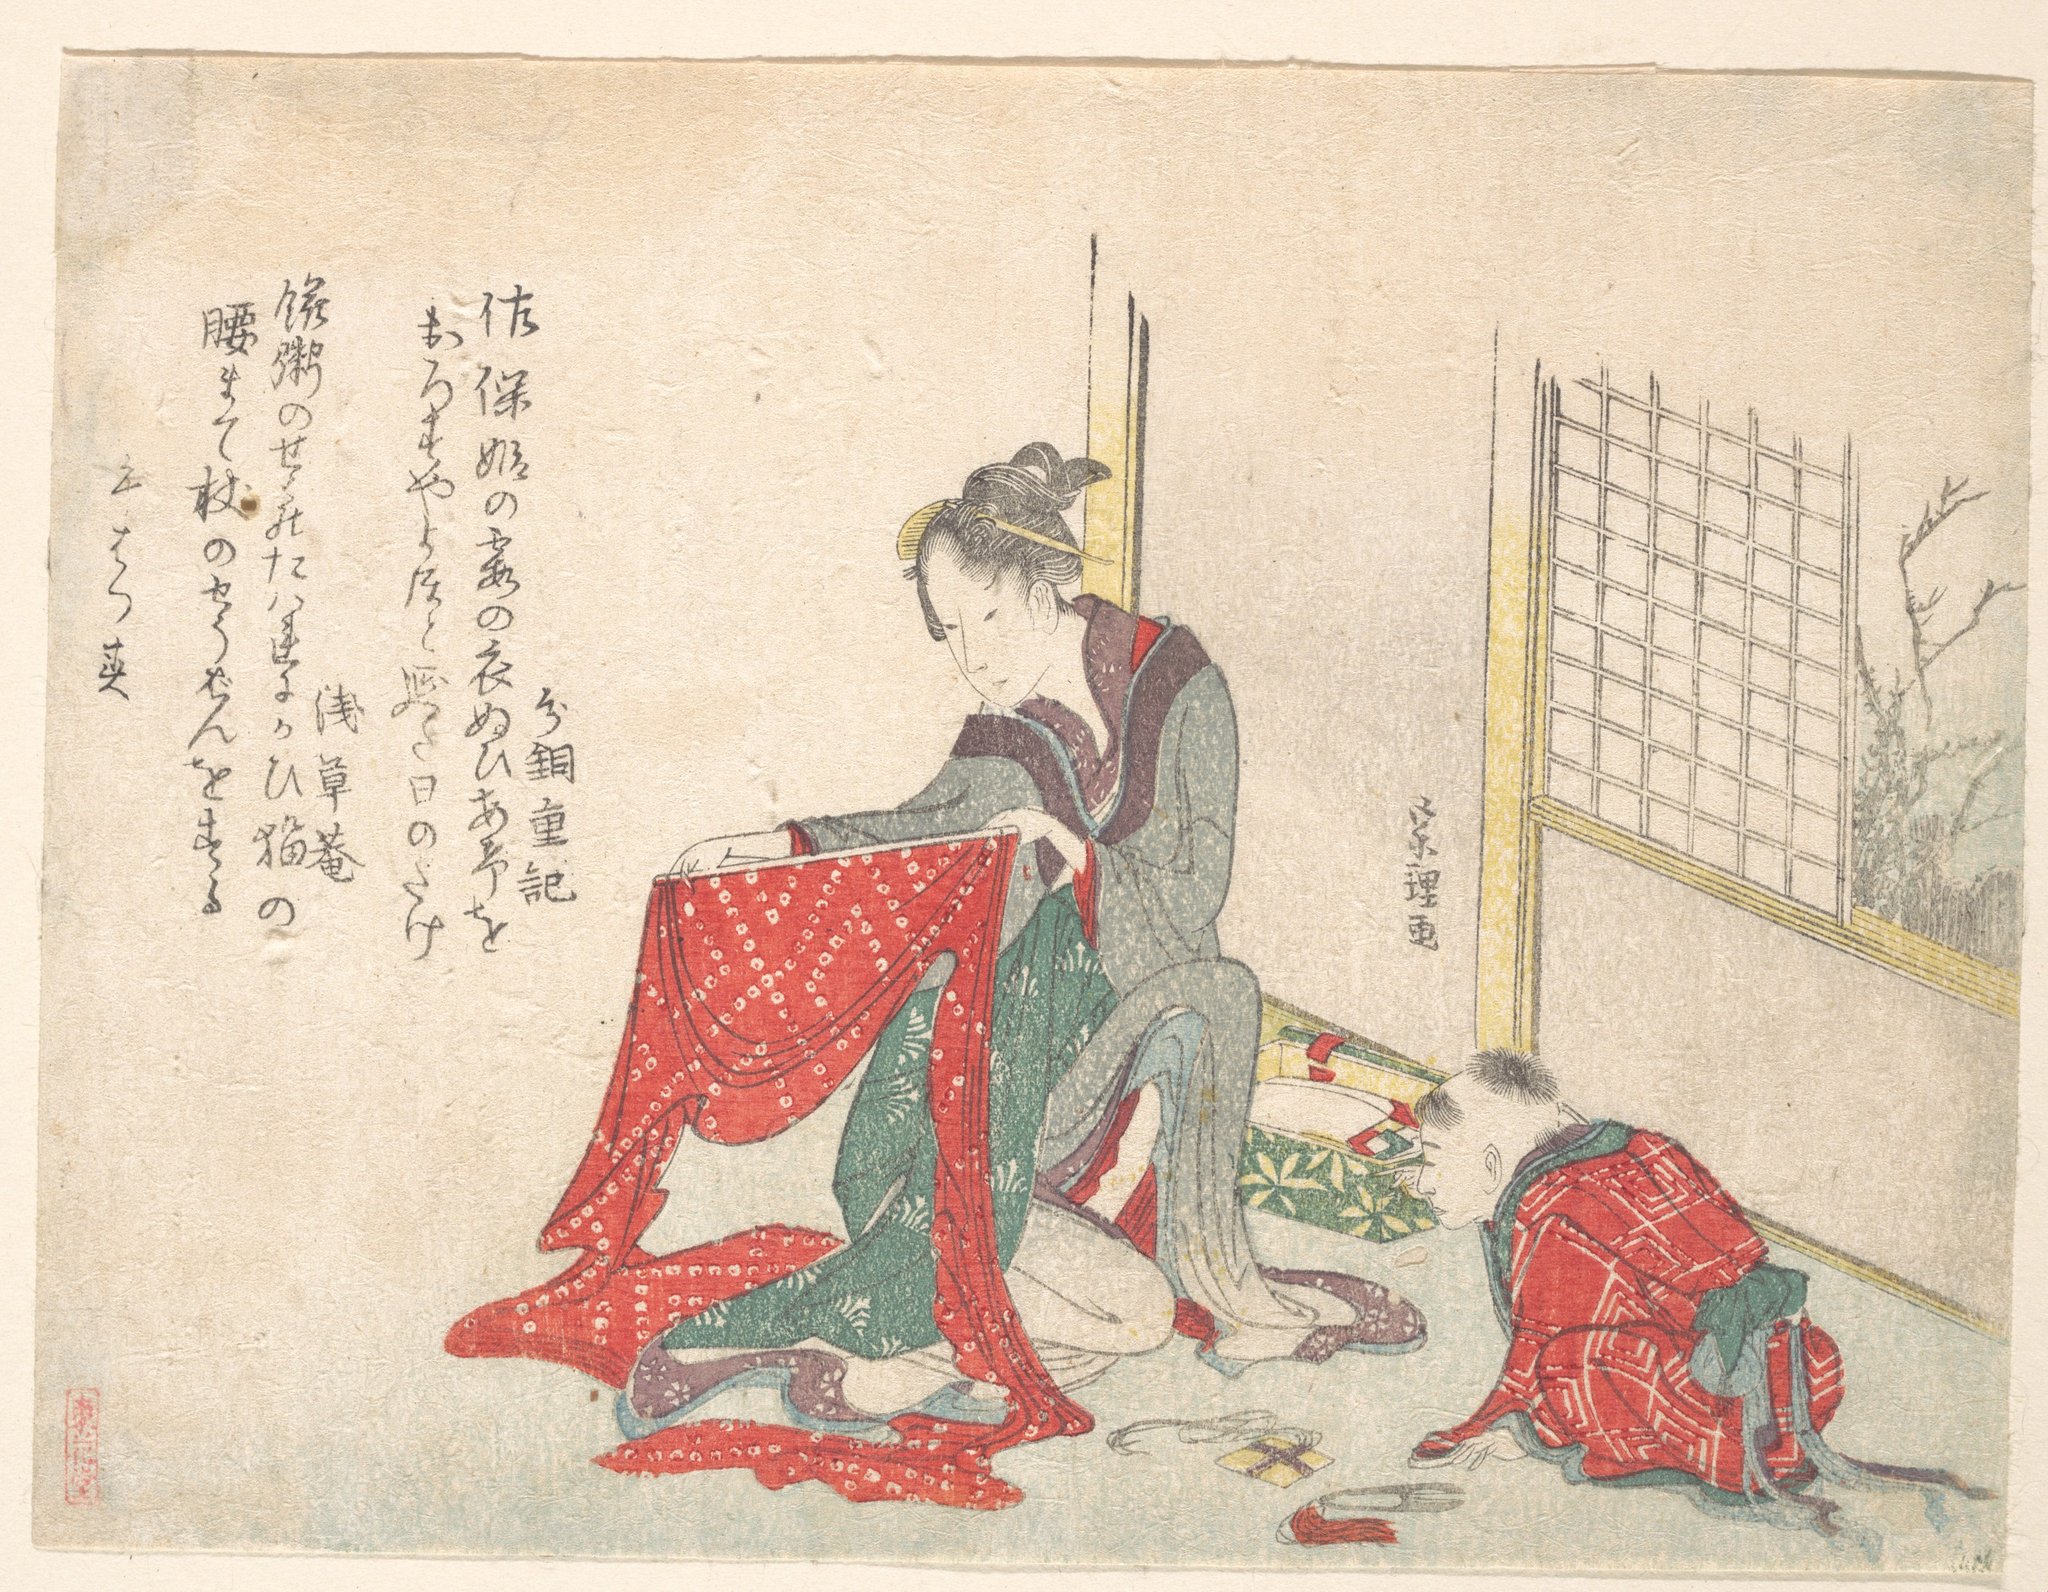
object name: woodblock print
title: Woman Folding Cloth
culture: japanese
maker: katsushika hokusai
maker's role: artist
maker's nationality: japanese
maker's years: 1760-1849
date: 1760-1849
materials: ink, paper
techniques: surimono, woodblock print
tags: boys,women